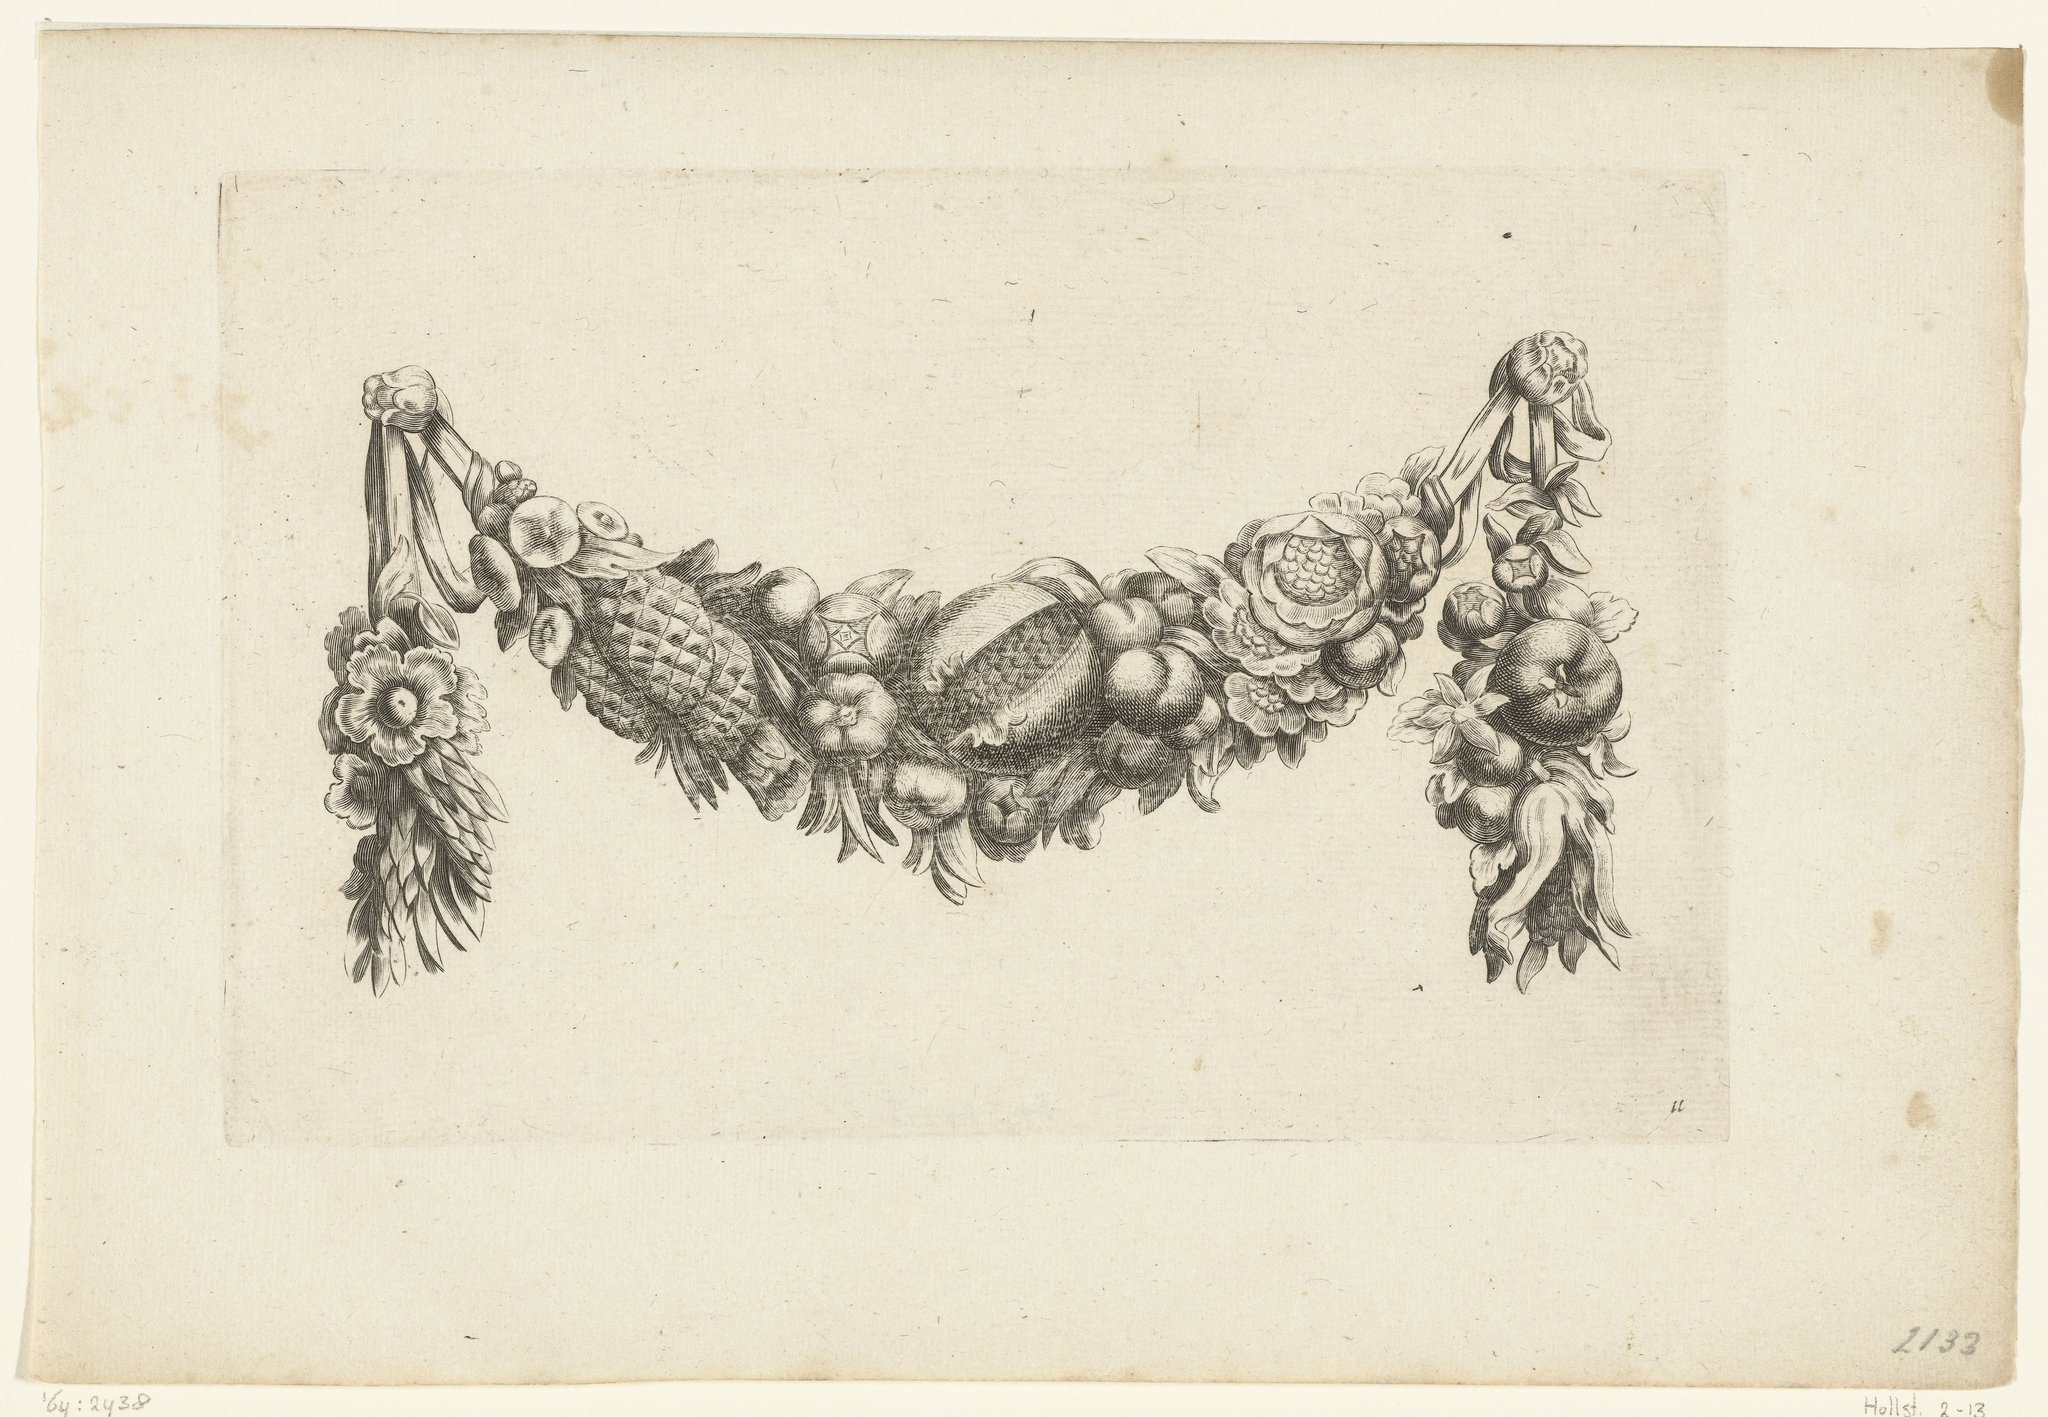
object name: print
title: Verscheide Nieuwe Festonnen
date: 1640-1655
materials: paper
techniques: engraving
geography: amsterdam